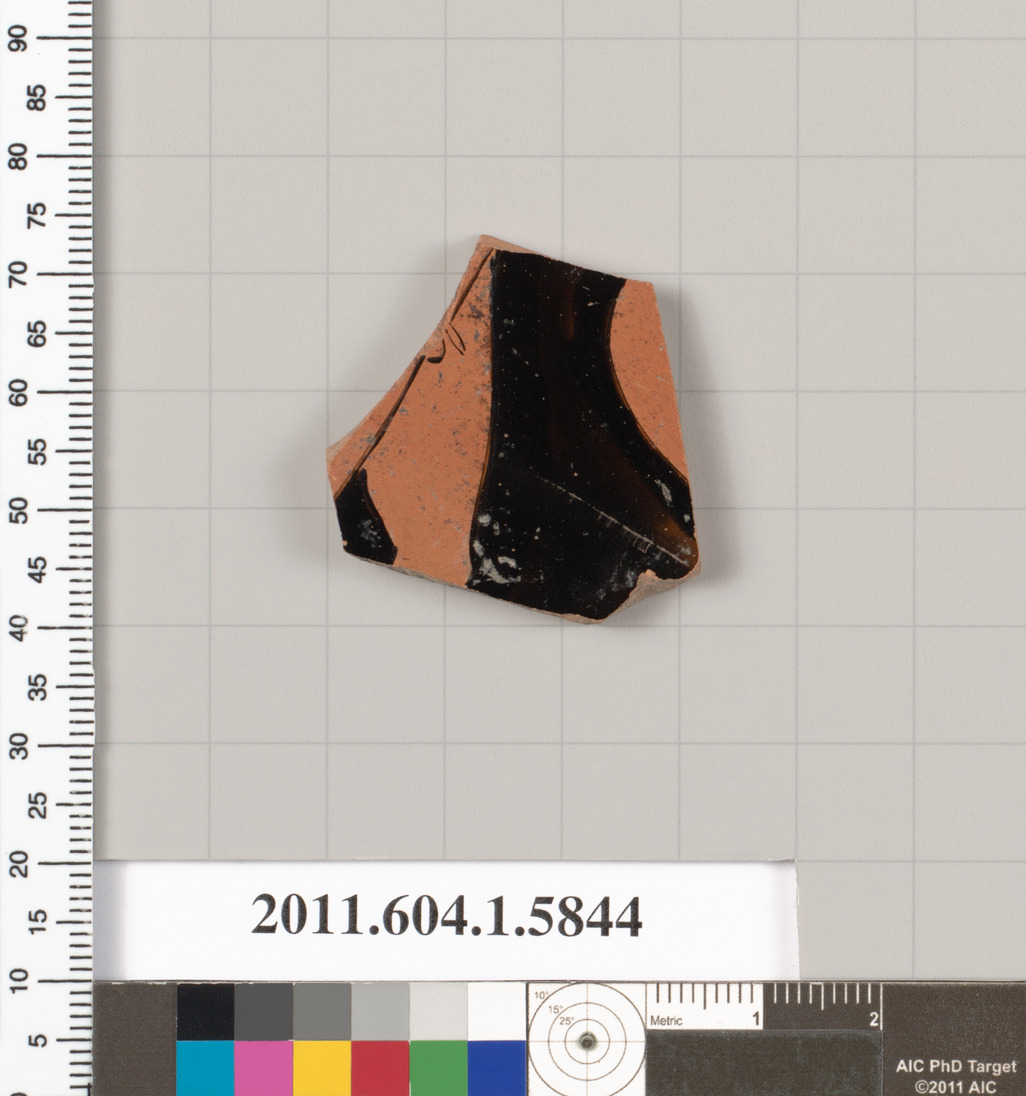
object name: kylix fragment, eye cup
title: Terracotta fragment of a kylix: eye-cup (drinking cup)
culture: greek, attic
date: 433-567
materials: terracotta